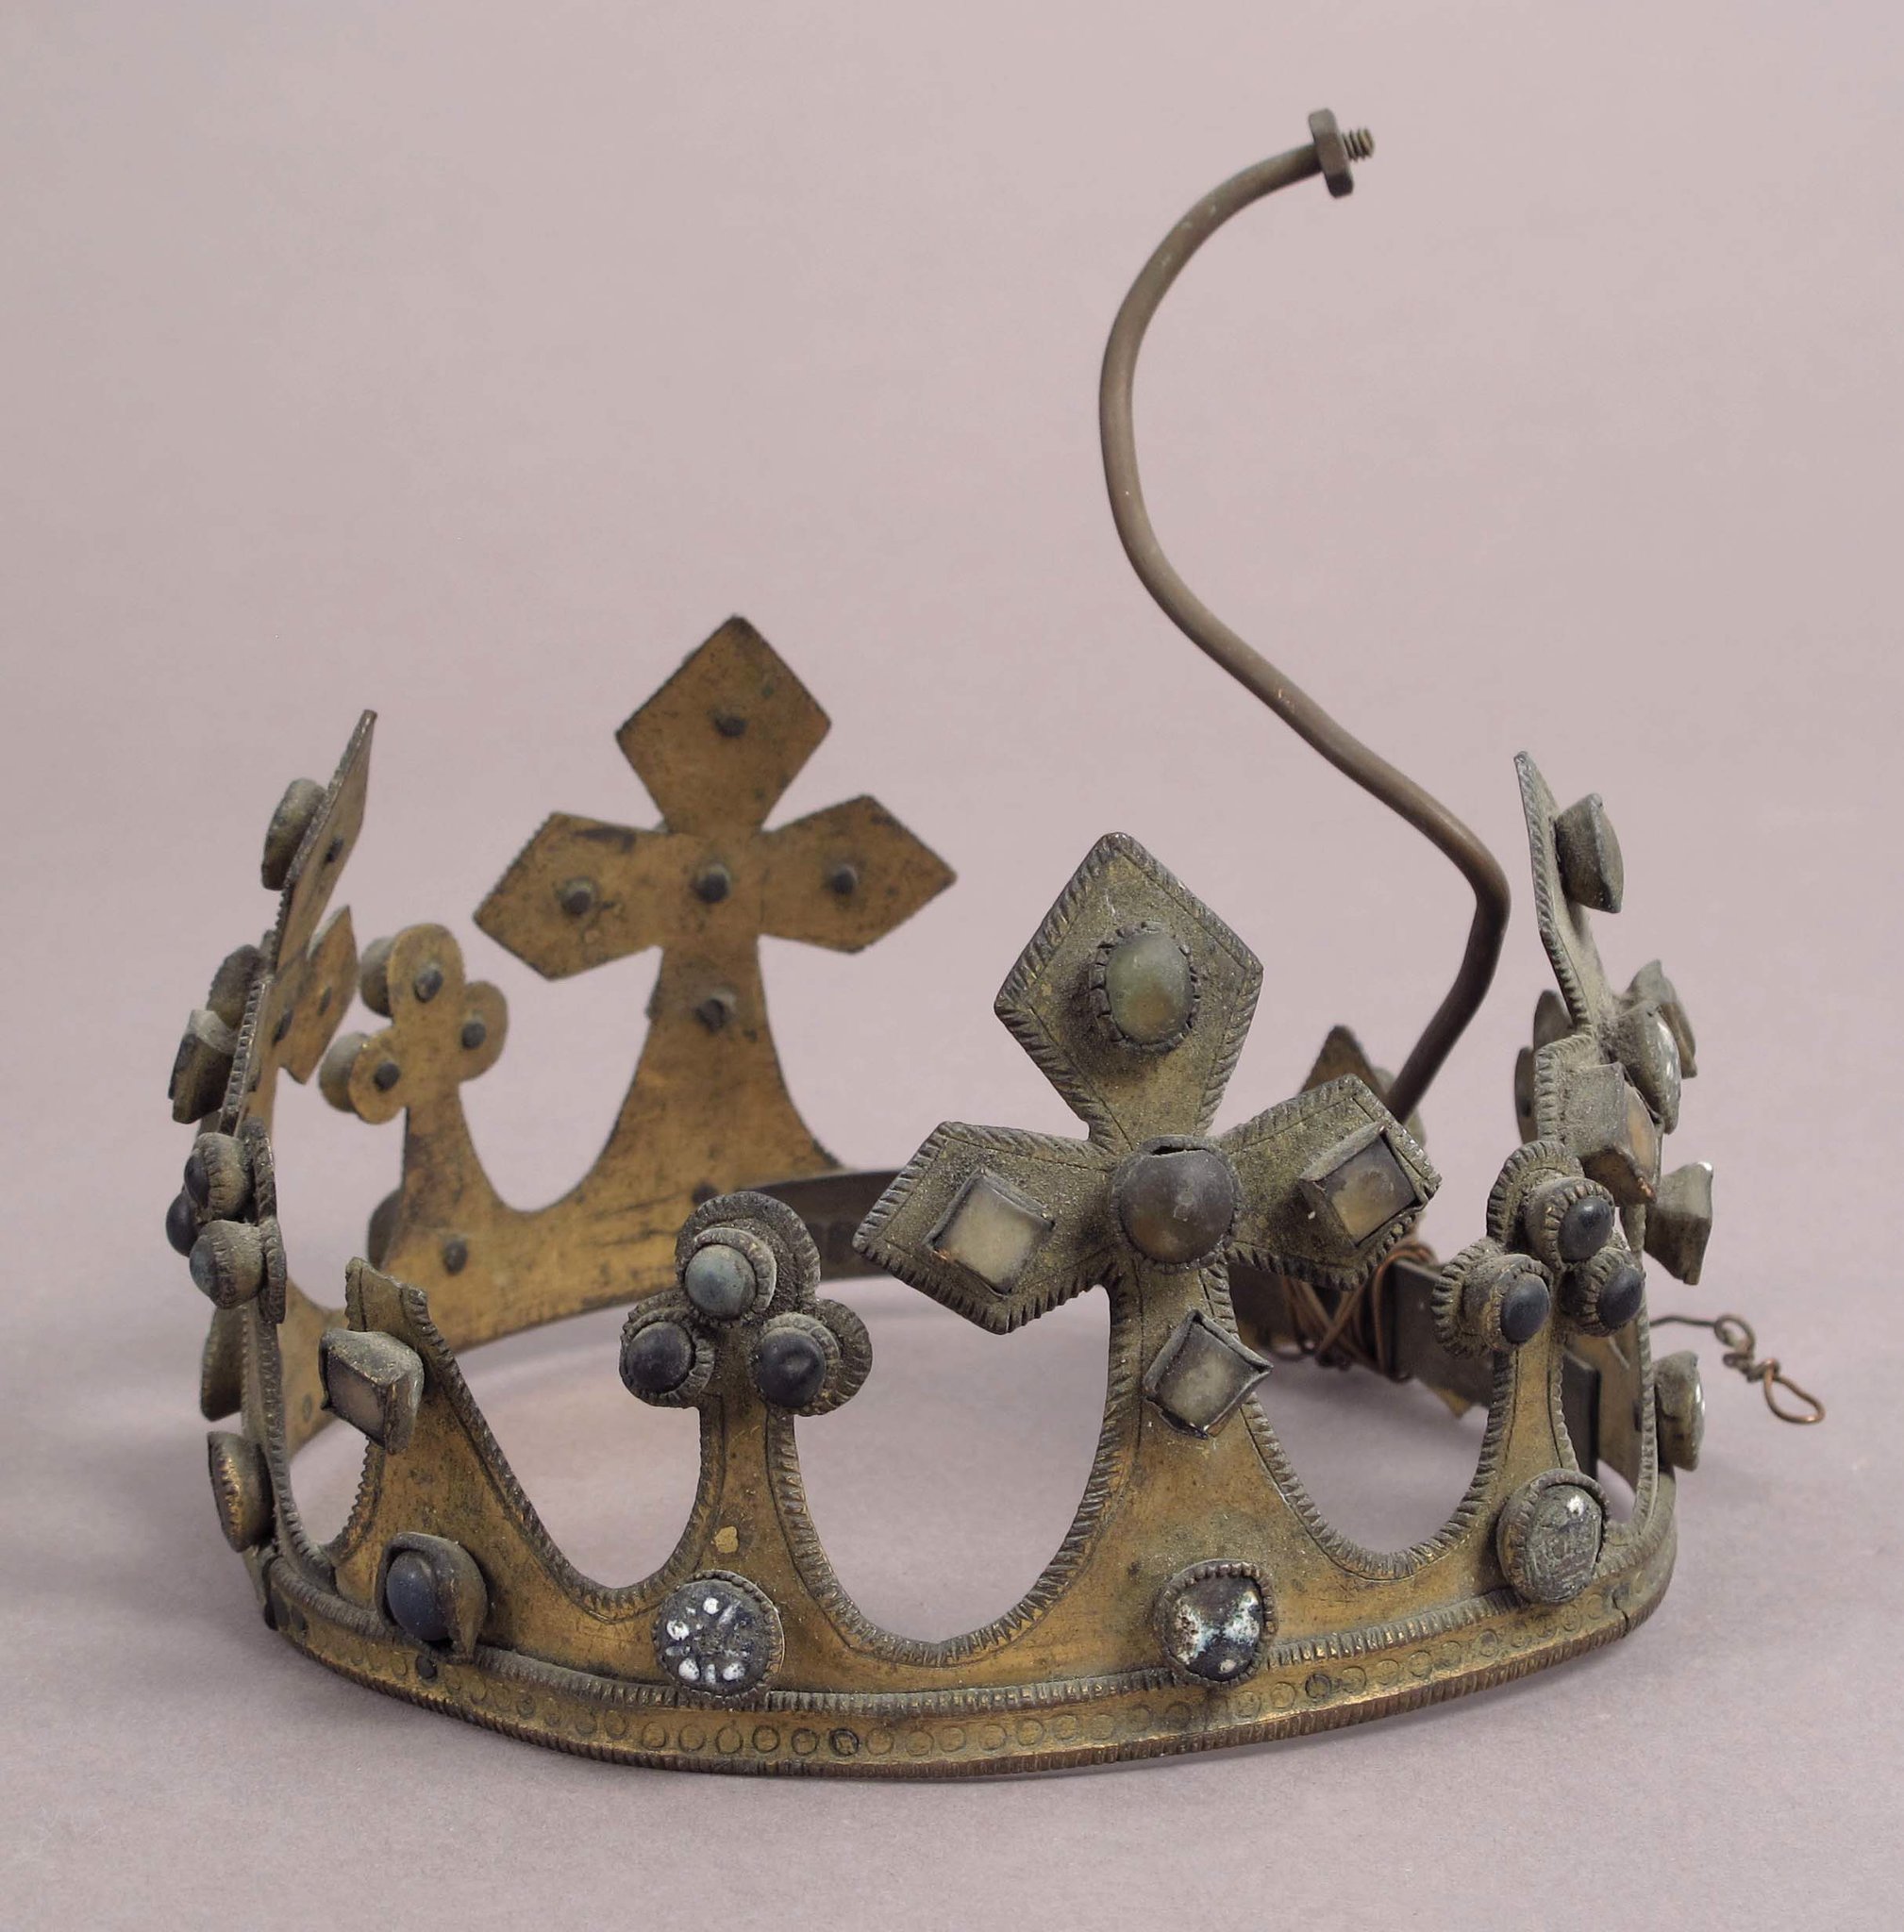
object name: crown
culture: french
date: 1801-1900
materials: copper alloy, enamel, gilt, glass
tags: crowns